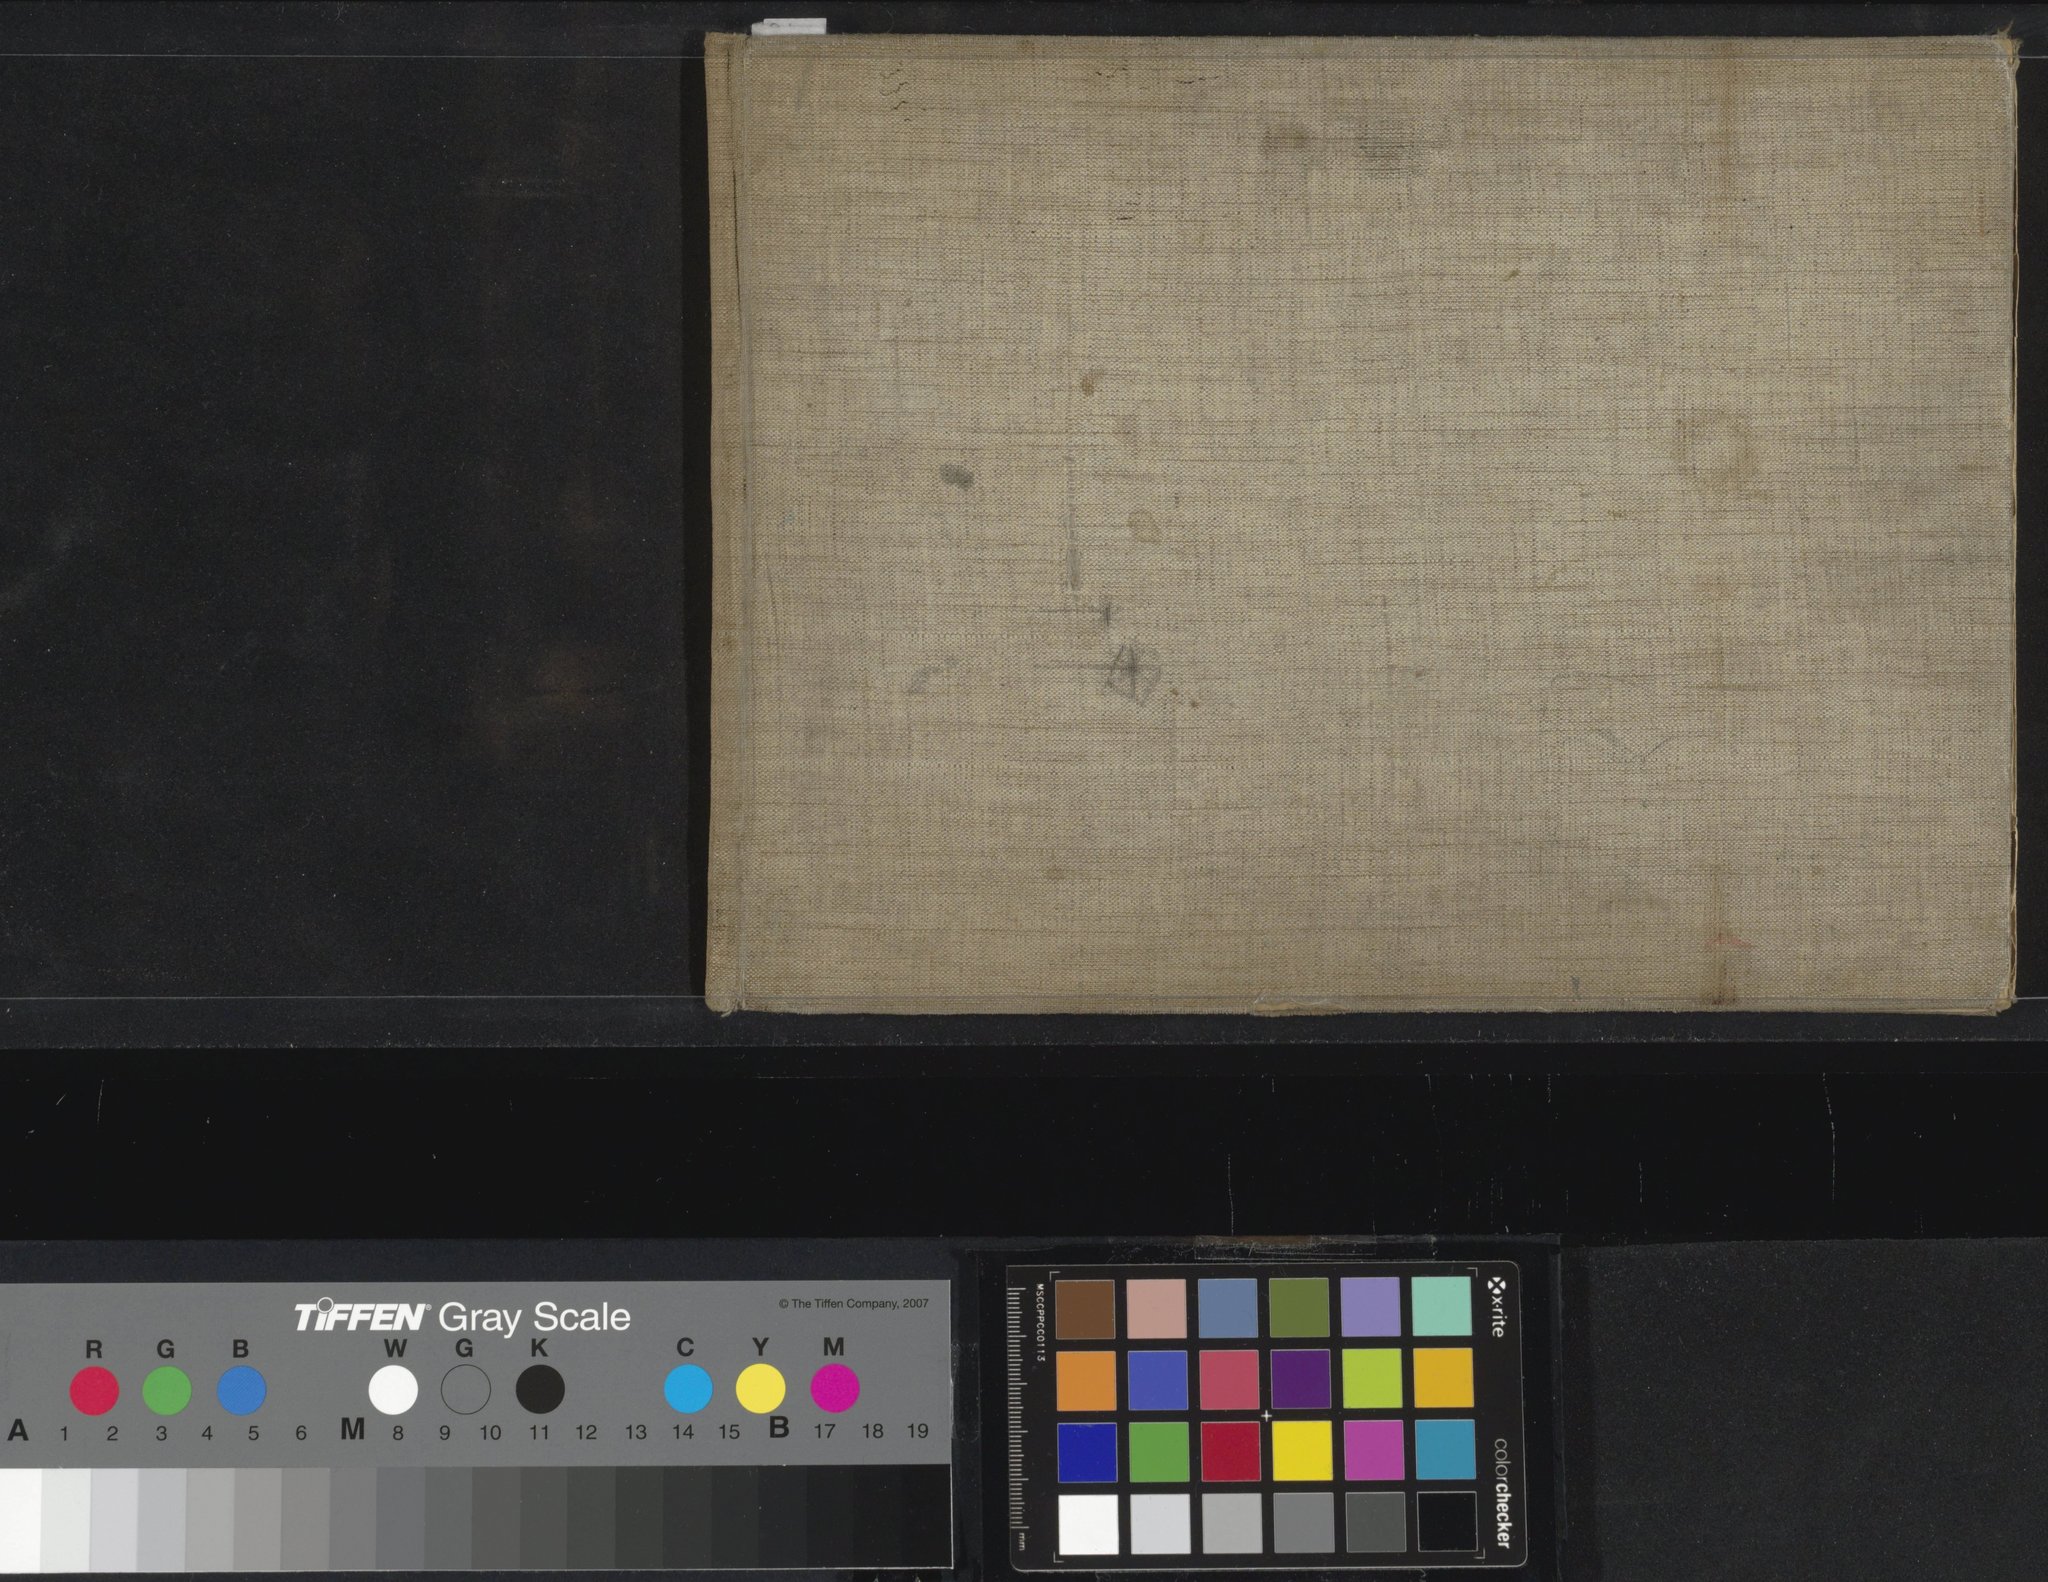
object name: sketchbook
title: Schetsboek met 11 bladen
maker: johanna van de kamer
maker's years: 1873-1922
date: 1890-1922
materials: cardboard, chalk, linen, paper, pencil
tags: drawing, adult woman, adult man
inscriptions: collector's mark: Lugt 2228a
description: Schetsboek bestaande uit 11 bladen met figuurstudies, waaronder mannen en vrouwen achter tekentafels.